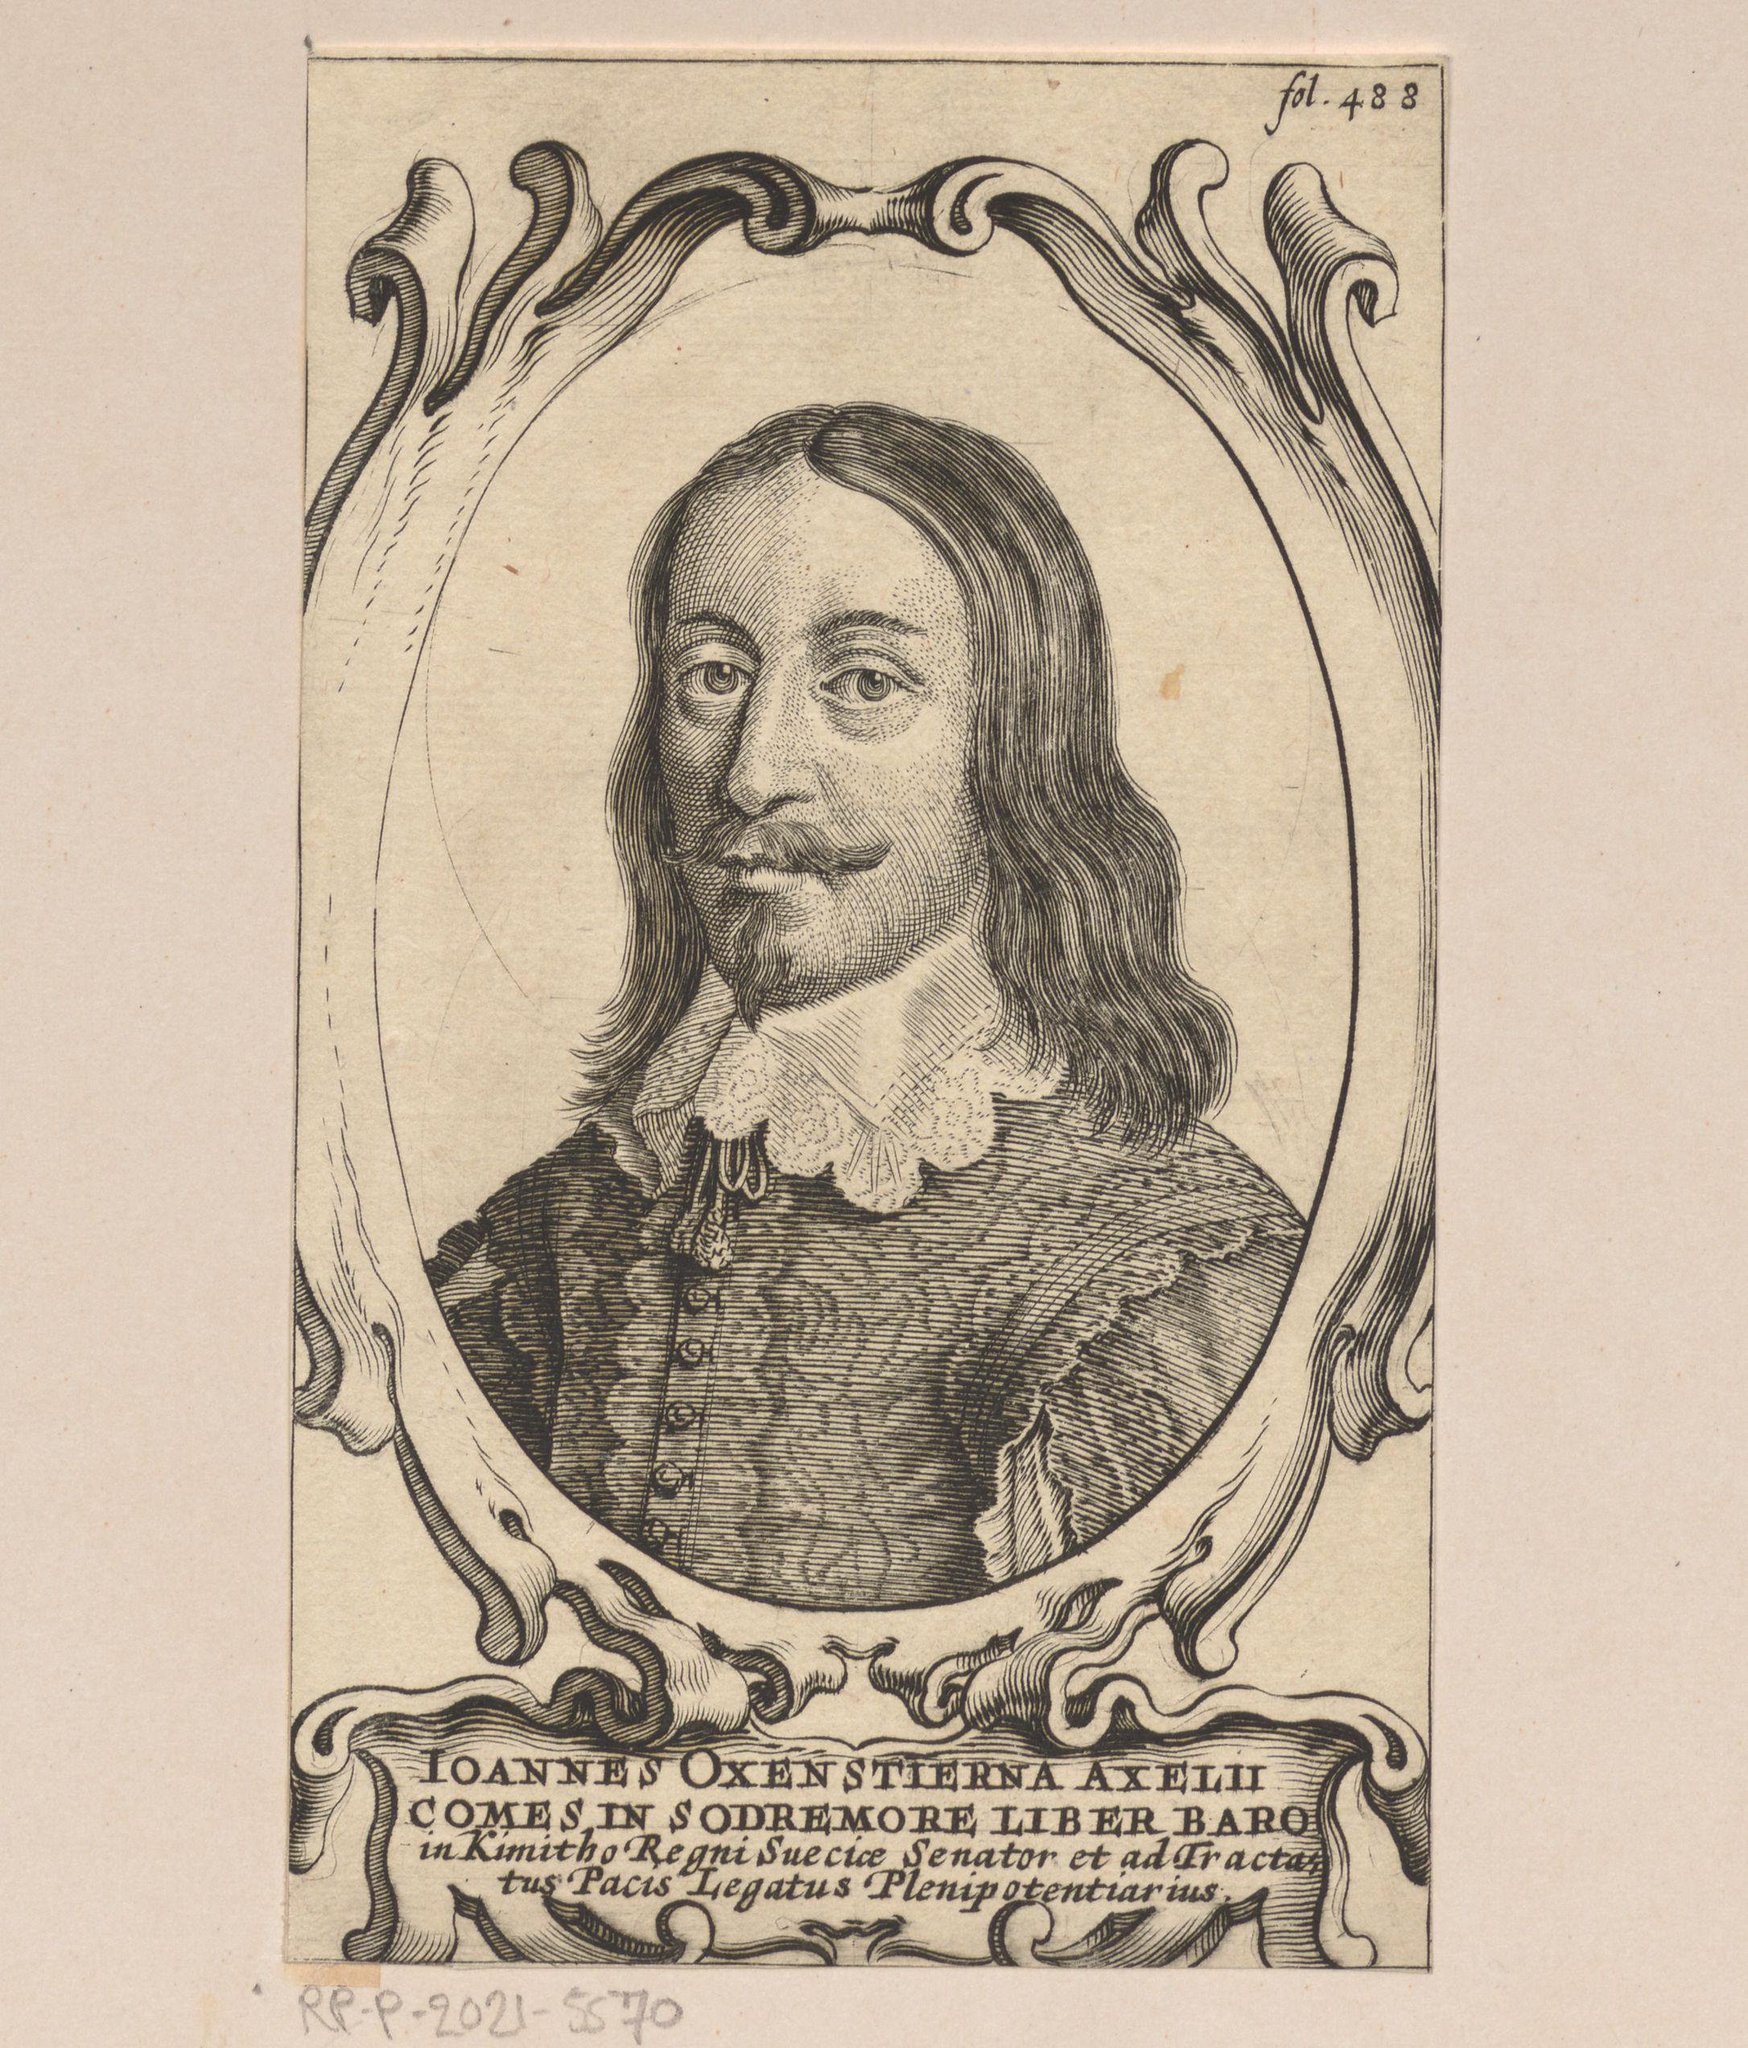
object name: print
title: Portret van Johan Oxenstierna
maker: Anonymous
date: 1640-1699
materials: paper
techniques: engraving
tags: historical persons